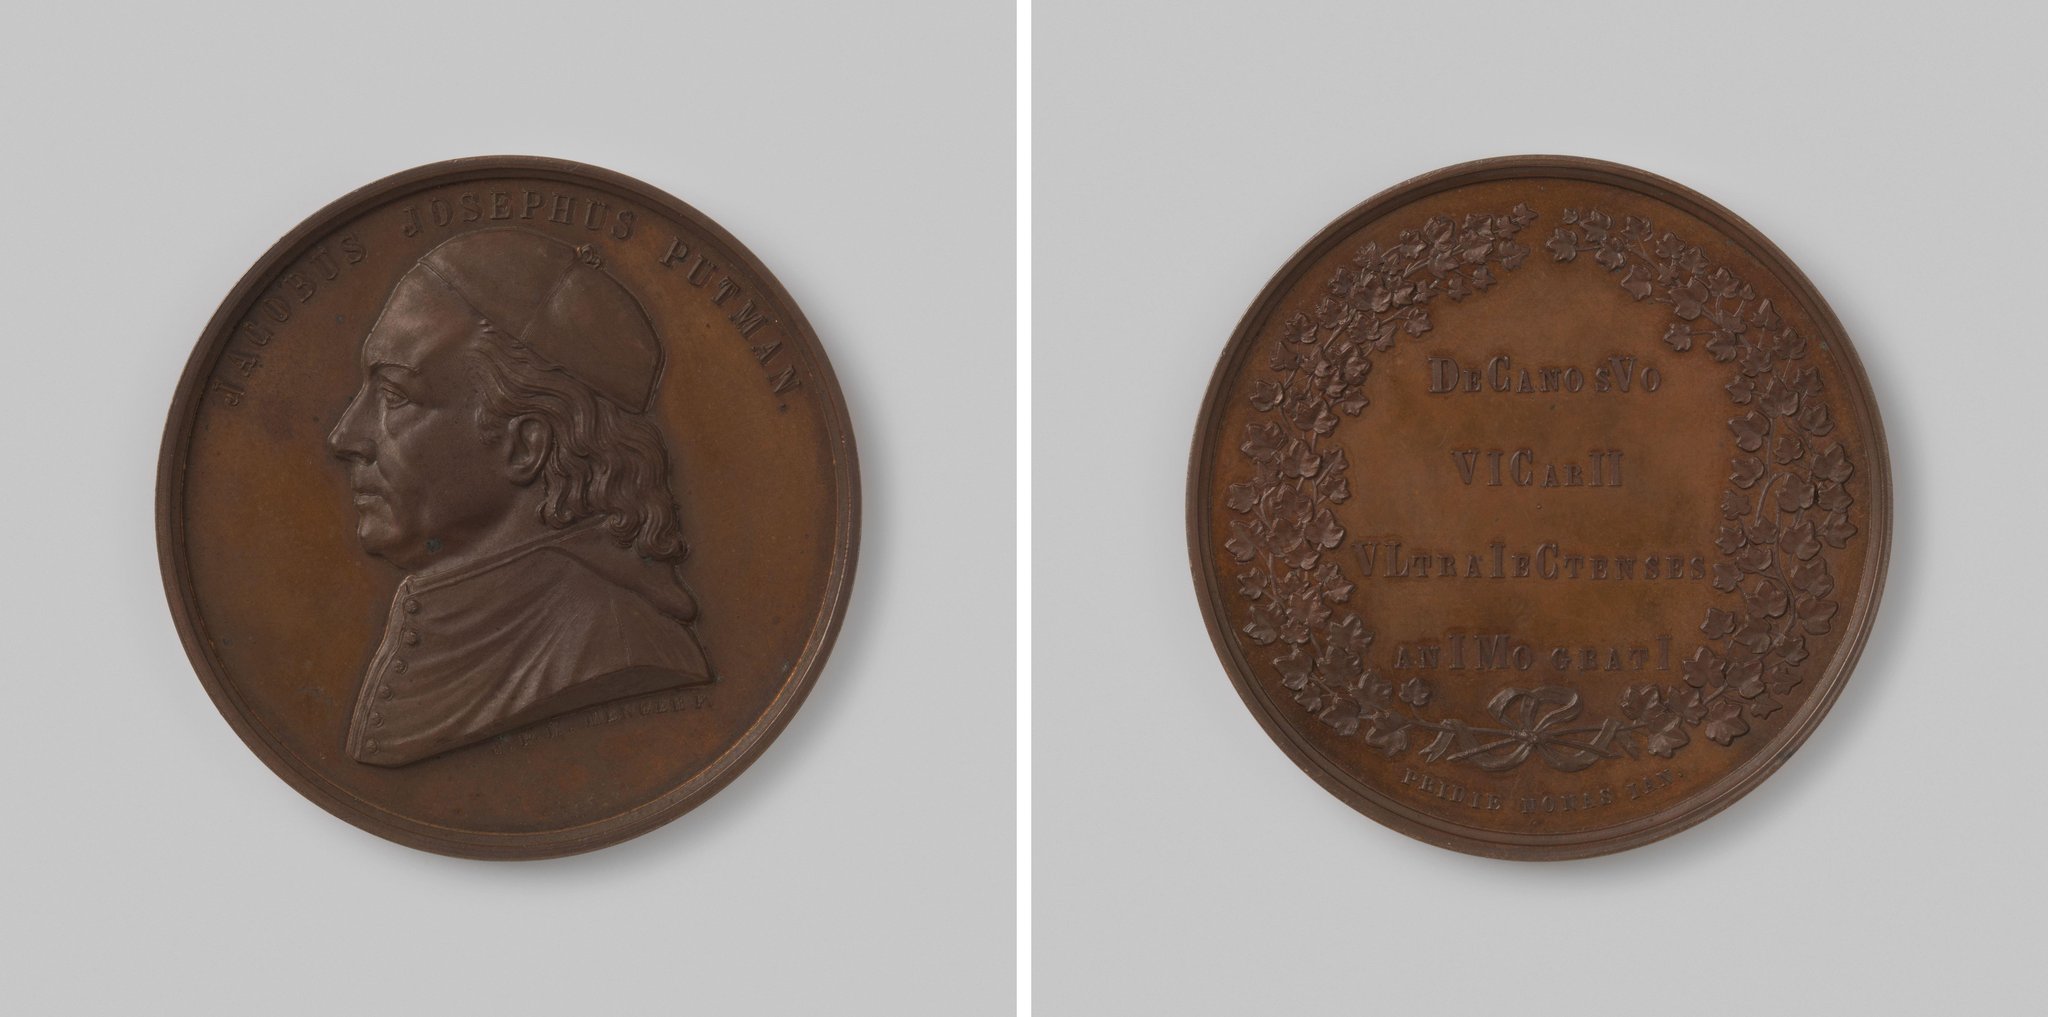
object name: history medal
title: Jacobus Josephus Putman 1871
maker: johan philip mathias menger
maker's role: medailleur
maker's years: 1845-1905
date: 1871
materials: bronze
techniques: striking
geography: utrecht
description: Bronzen penning, op de voorzijde het borstbeeld van Putman naar links met bovenaan omschrift, op de keerzijde vier regels tekst tussen samengestrikte klimoptakken, met afsnedetekst.